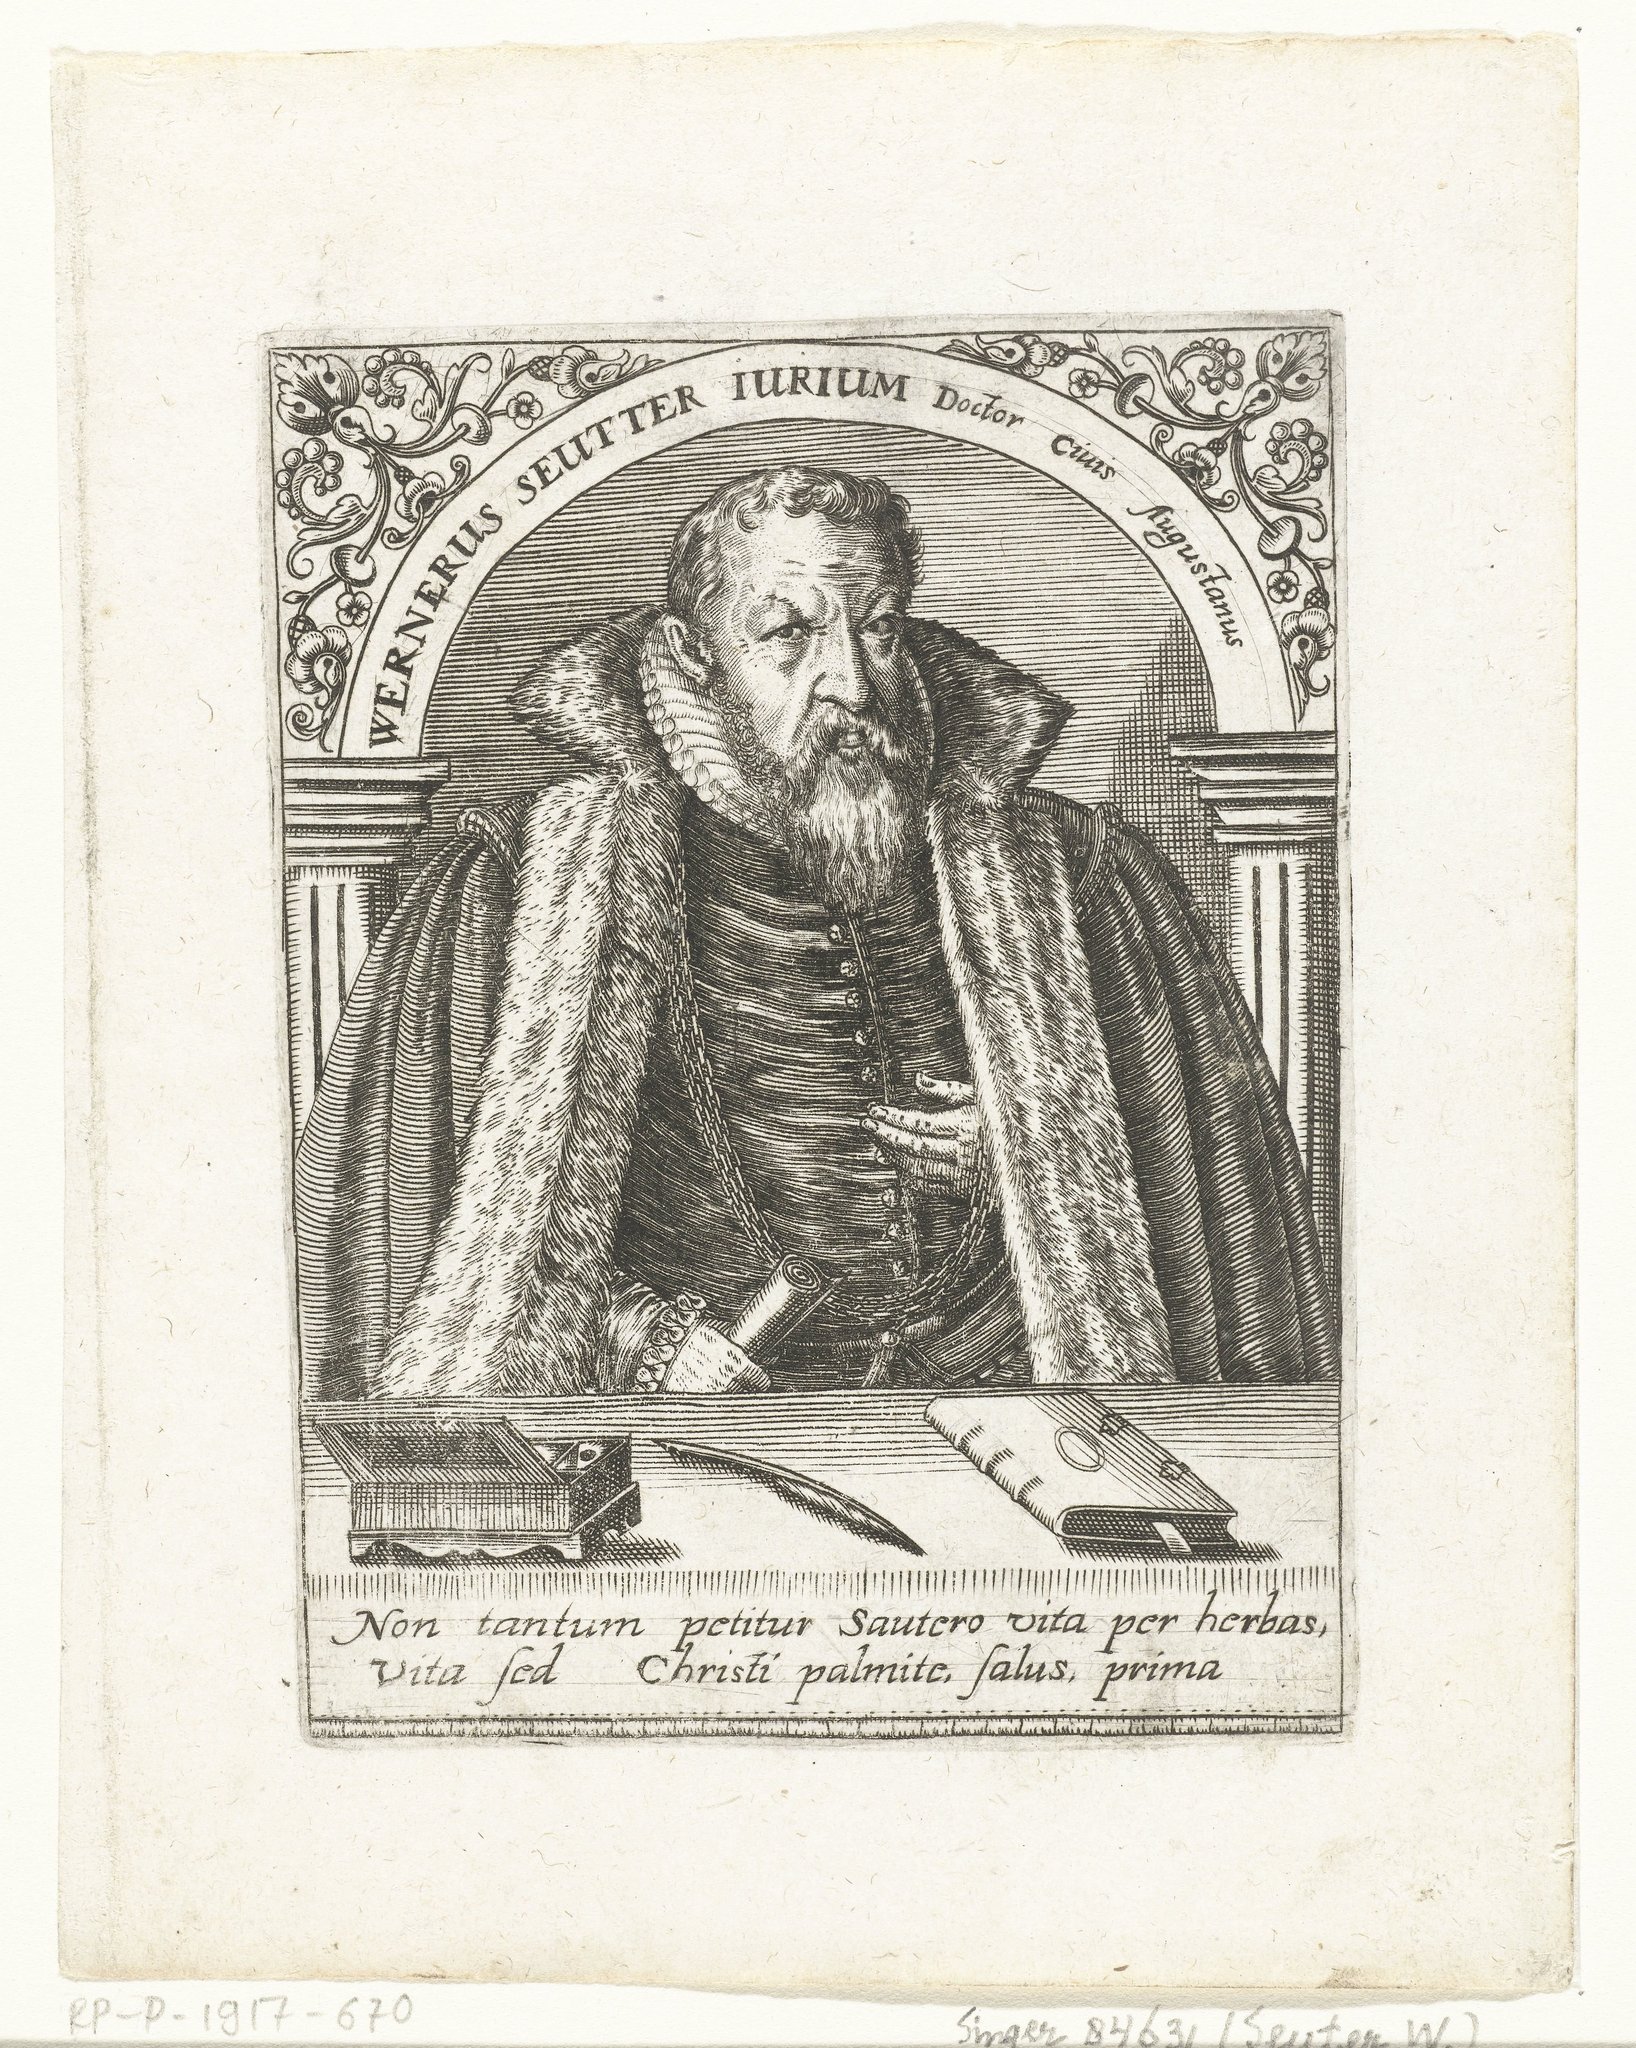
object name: book illustration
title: Portret van Werner Seuter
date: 1597-1599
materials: paper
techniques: engraving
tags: werner seutter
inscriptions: collector's mark: Lugt 2228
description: Gemaakt voor: J.J. Boissard, Icones virorum illustrium doctrina &c eruditione praestanti um contines. Frankfurt am Main: de Bry, 1597-1599.